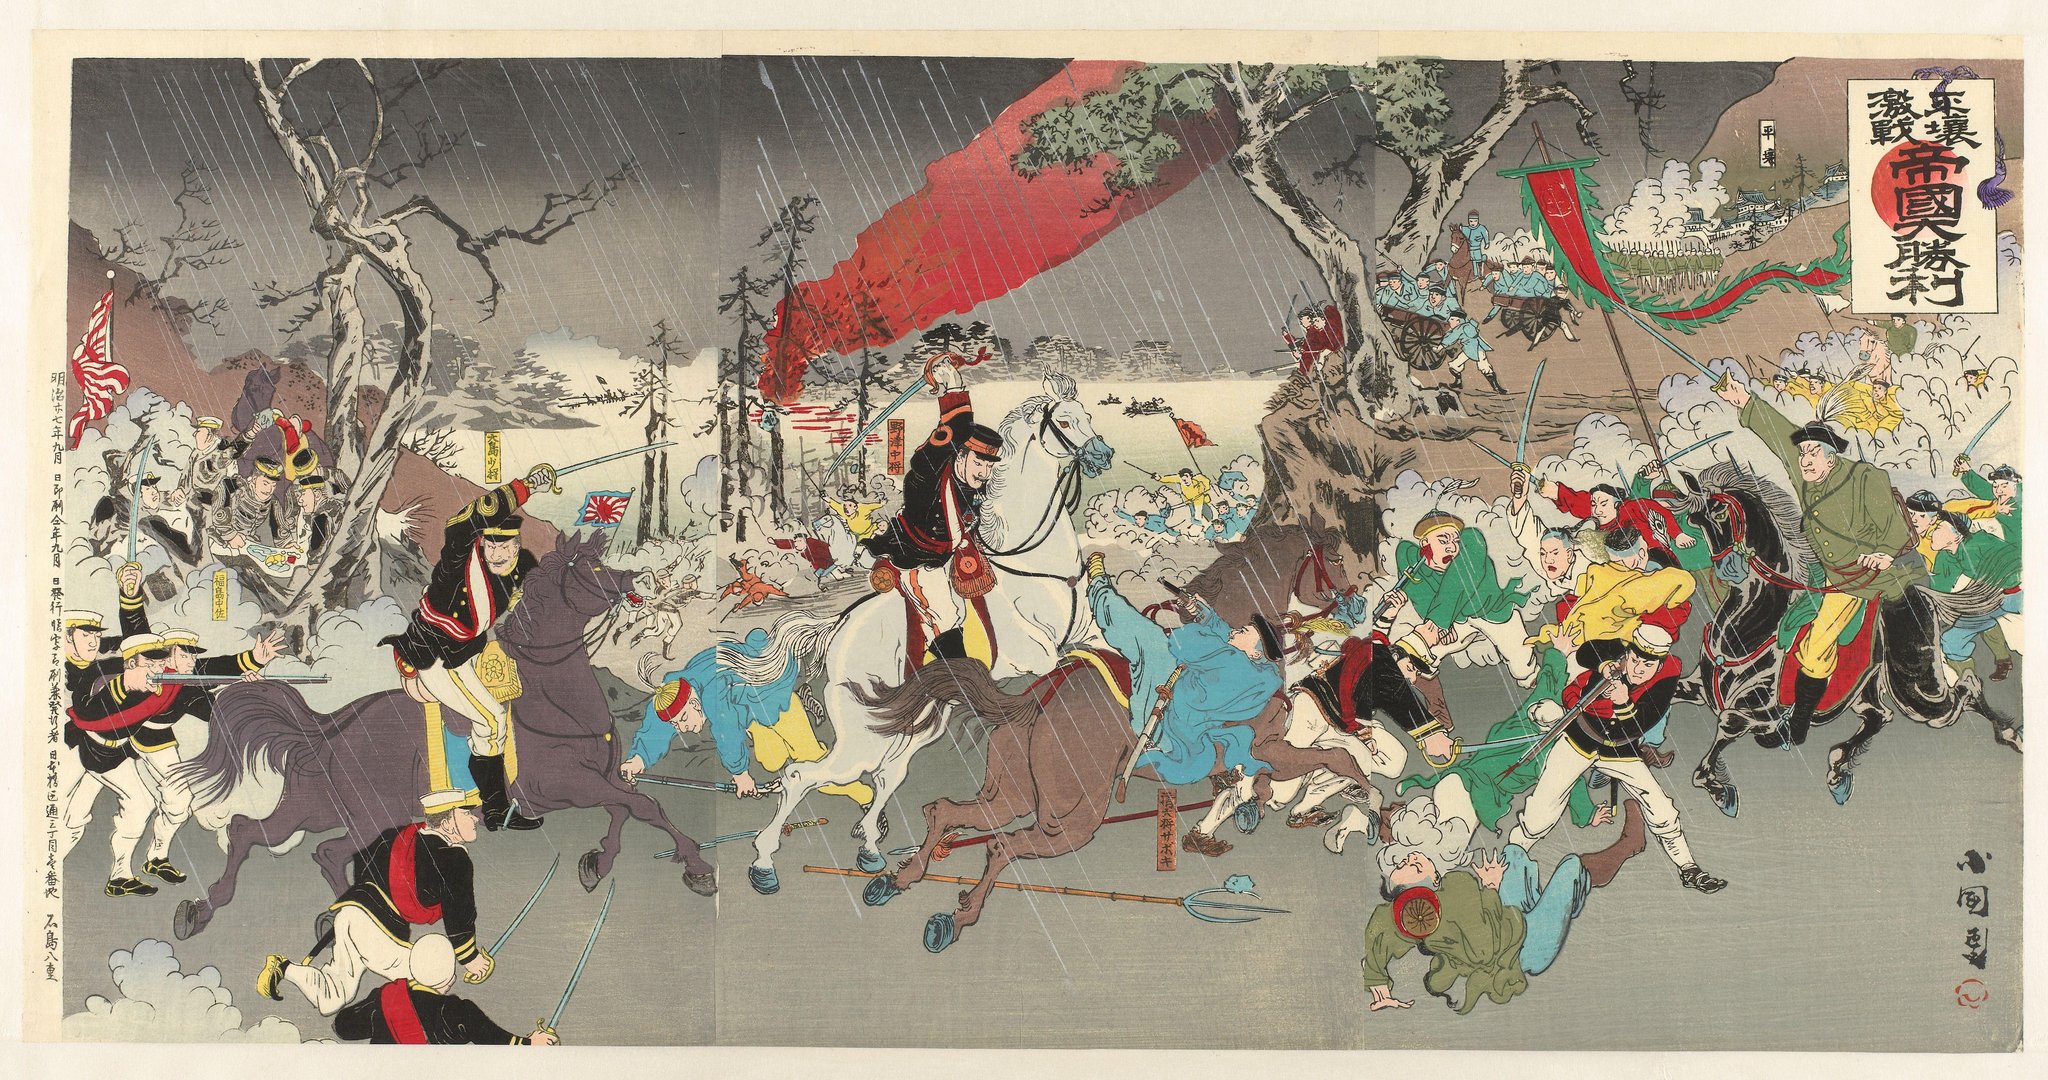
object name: triptych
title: Heijô gekisen teikoku daishôri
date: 1894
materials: paper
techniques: woodcut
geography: japan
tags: riding a horse, ass, or mule; rider, horseman, battle, rain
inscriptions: label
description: Onder leiding van Luitenant-Generaal Nozu Michitsura (midden), en Generaal-Majoor Ôshima Yoshimasa werd op de ochtend van 15 september 1894 een aanval gelanceerd op de stad Pyongyang. Na een strijd van meer dan vierentwintig uur had het Japanse leger de stad overwonnen.